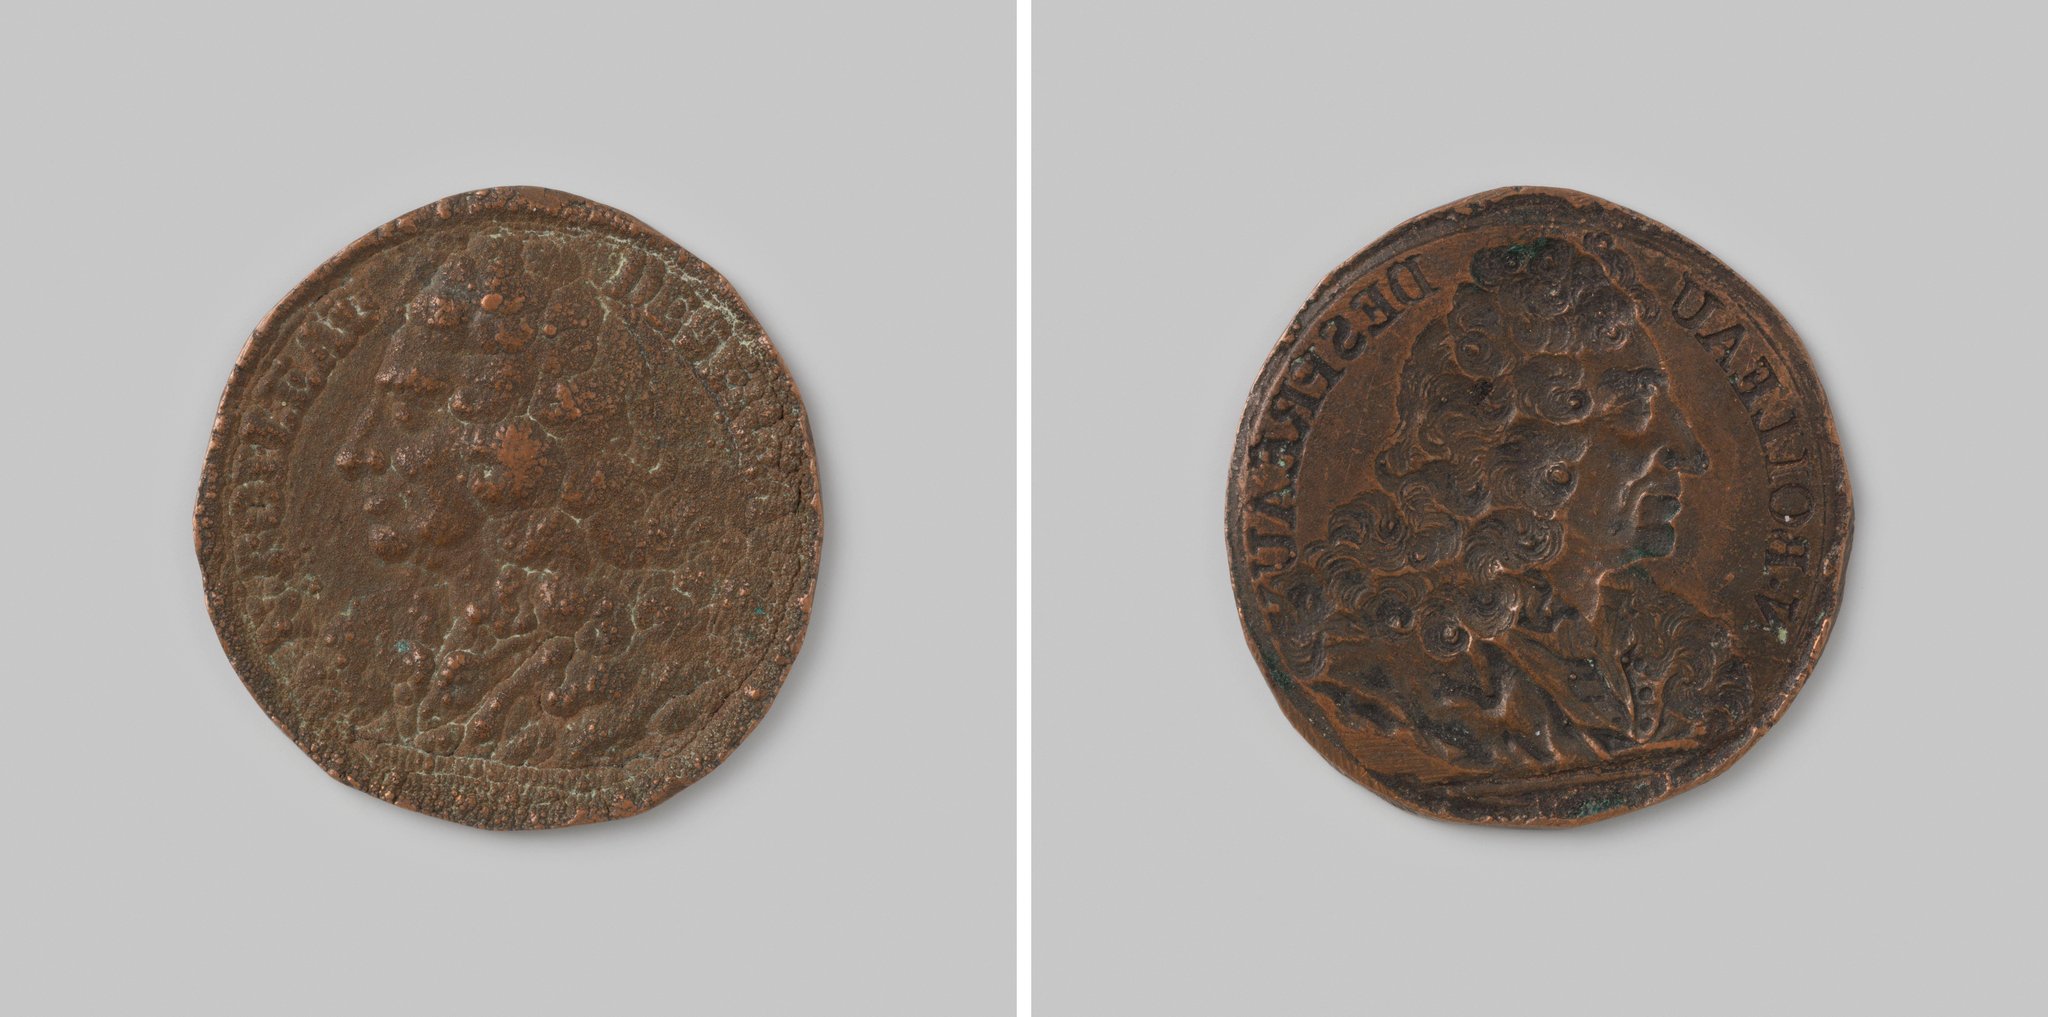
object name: history medal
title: Overlijden van Nicolas Boileau Despreau 1711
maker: jean dassier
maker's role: medailleur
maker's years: 1676-1763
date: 1711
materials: copper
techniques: galvanoplasty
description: Galvanoplastische afdruk in koper van de voorzijde een penning, borstbeeld naar links met omschrift.